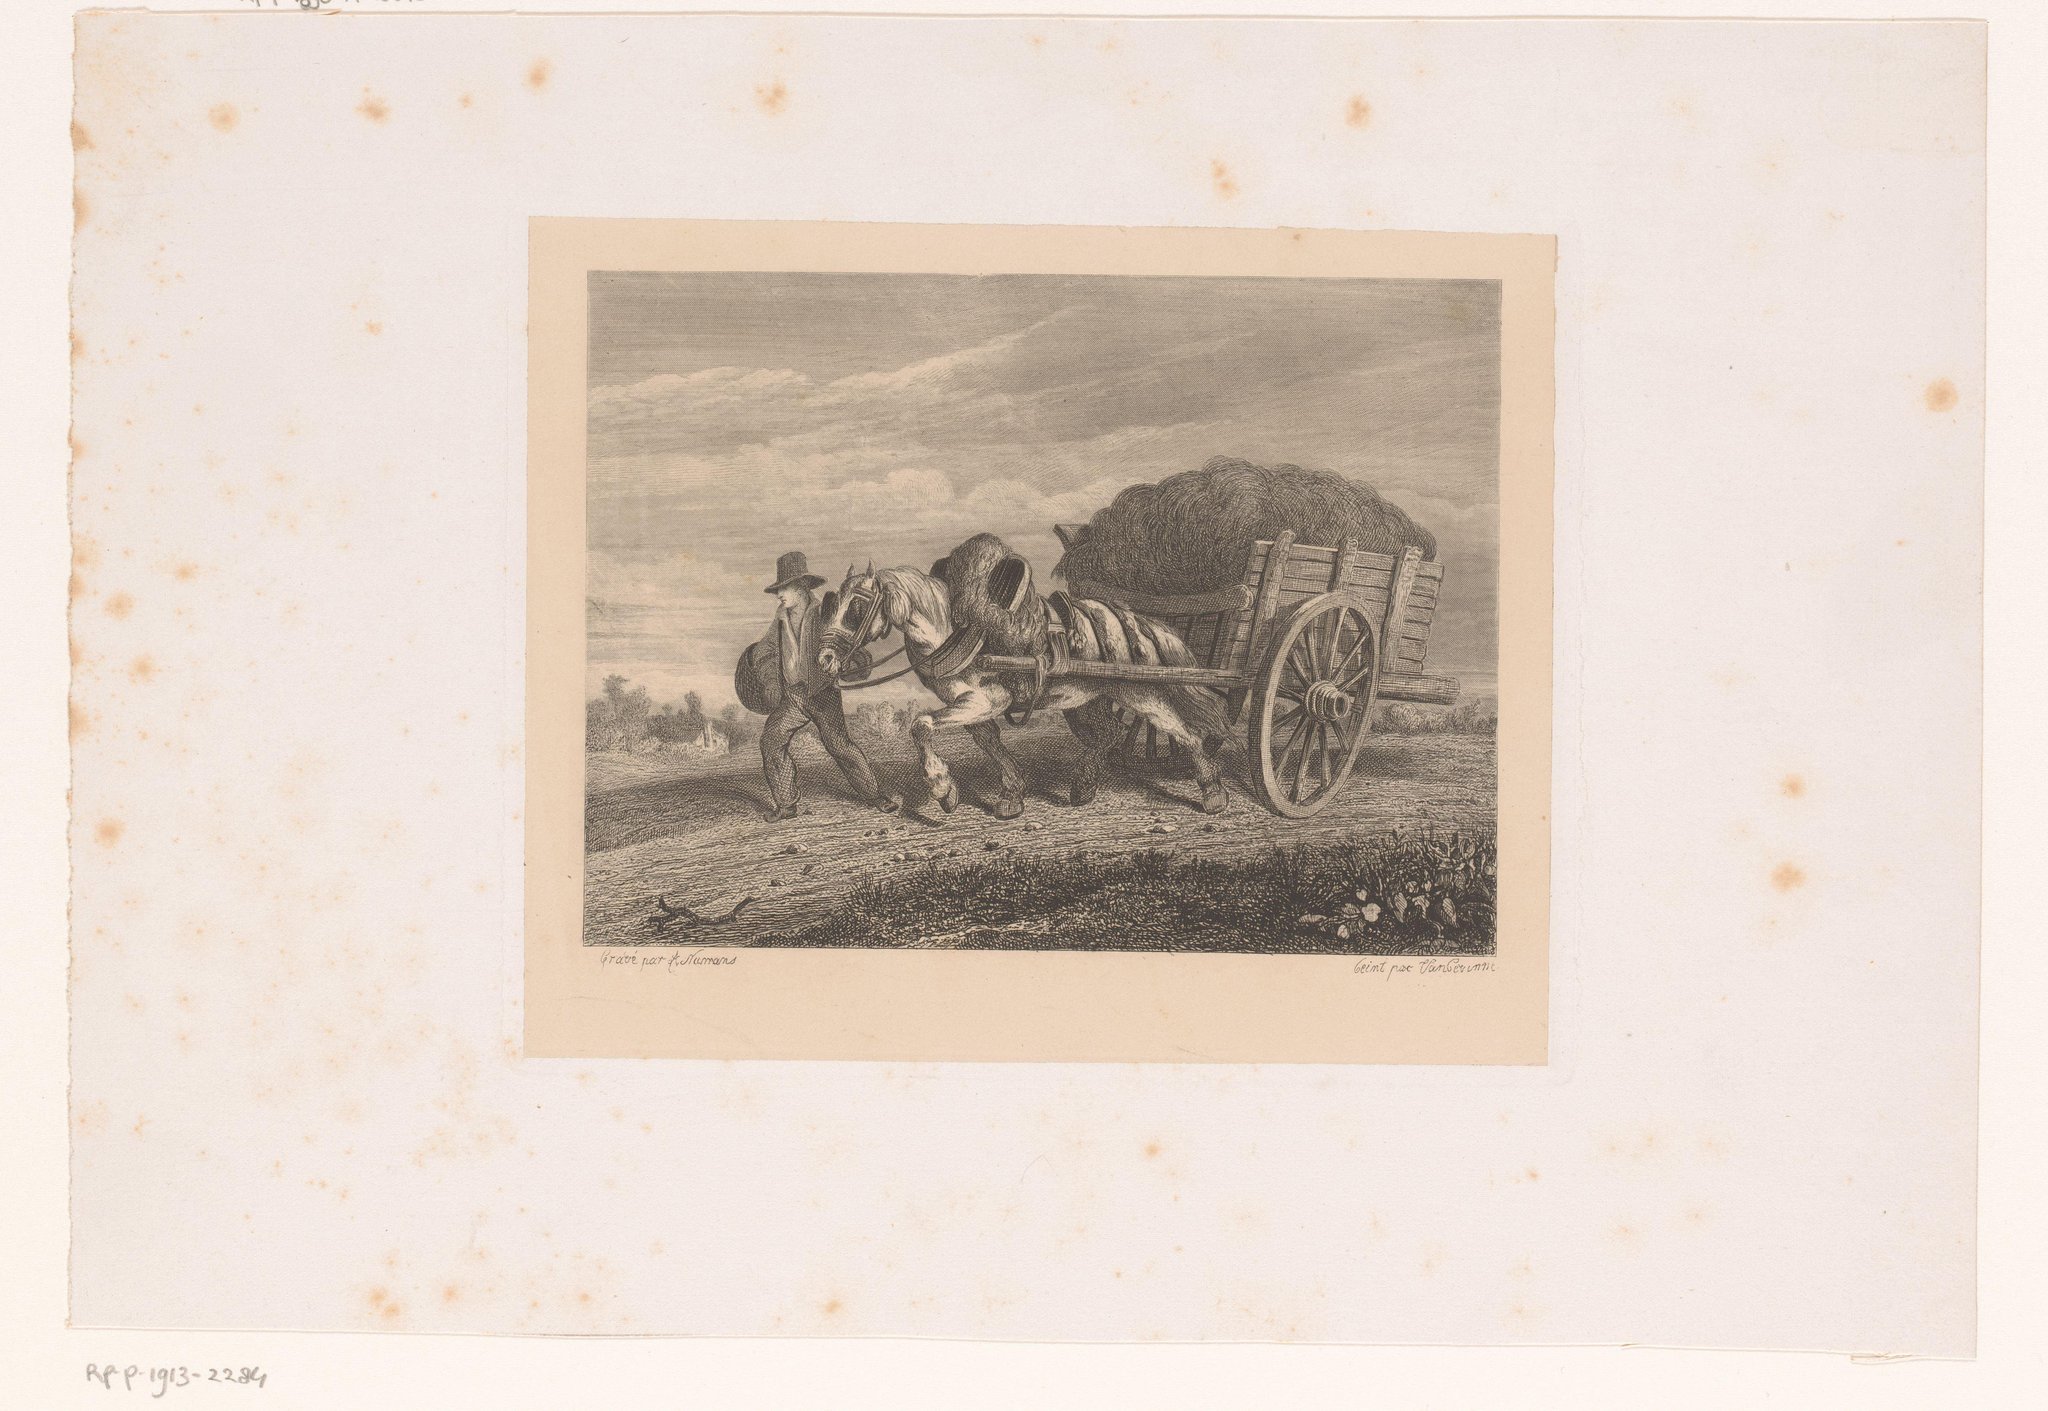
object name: print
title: Boer lopend over een akker met paard en hooiwagen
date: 1833-1870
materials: paper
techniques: etching, roulette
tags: horses and kindred animals, adult man, hay-wagon, two-wheeled vehicle drawn by one animal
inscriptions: mark: ‘Peint par Van[perinne].’, collector's mark: Lugt 2228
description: Prent verschenen in: De Vlaamsche School 16 (1870).